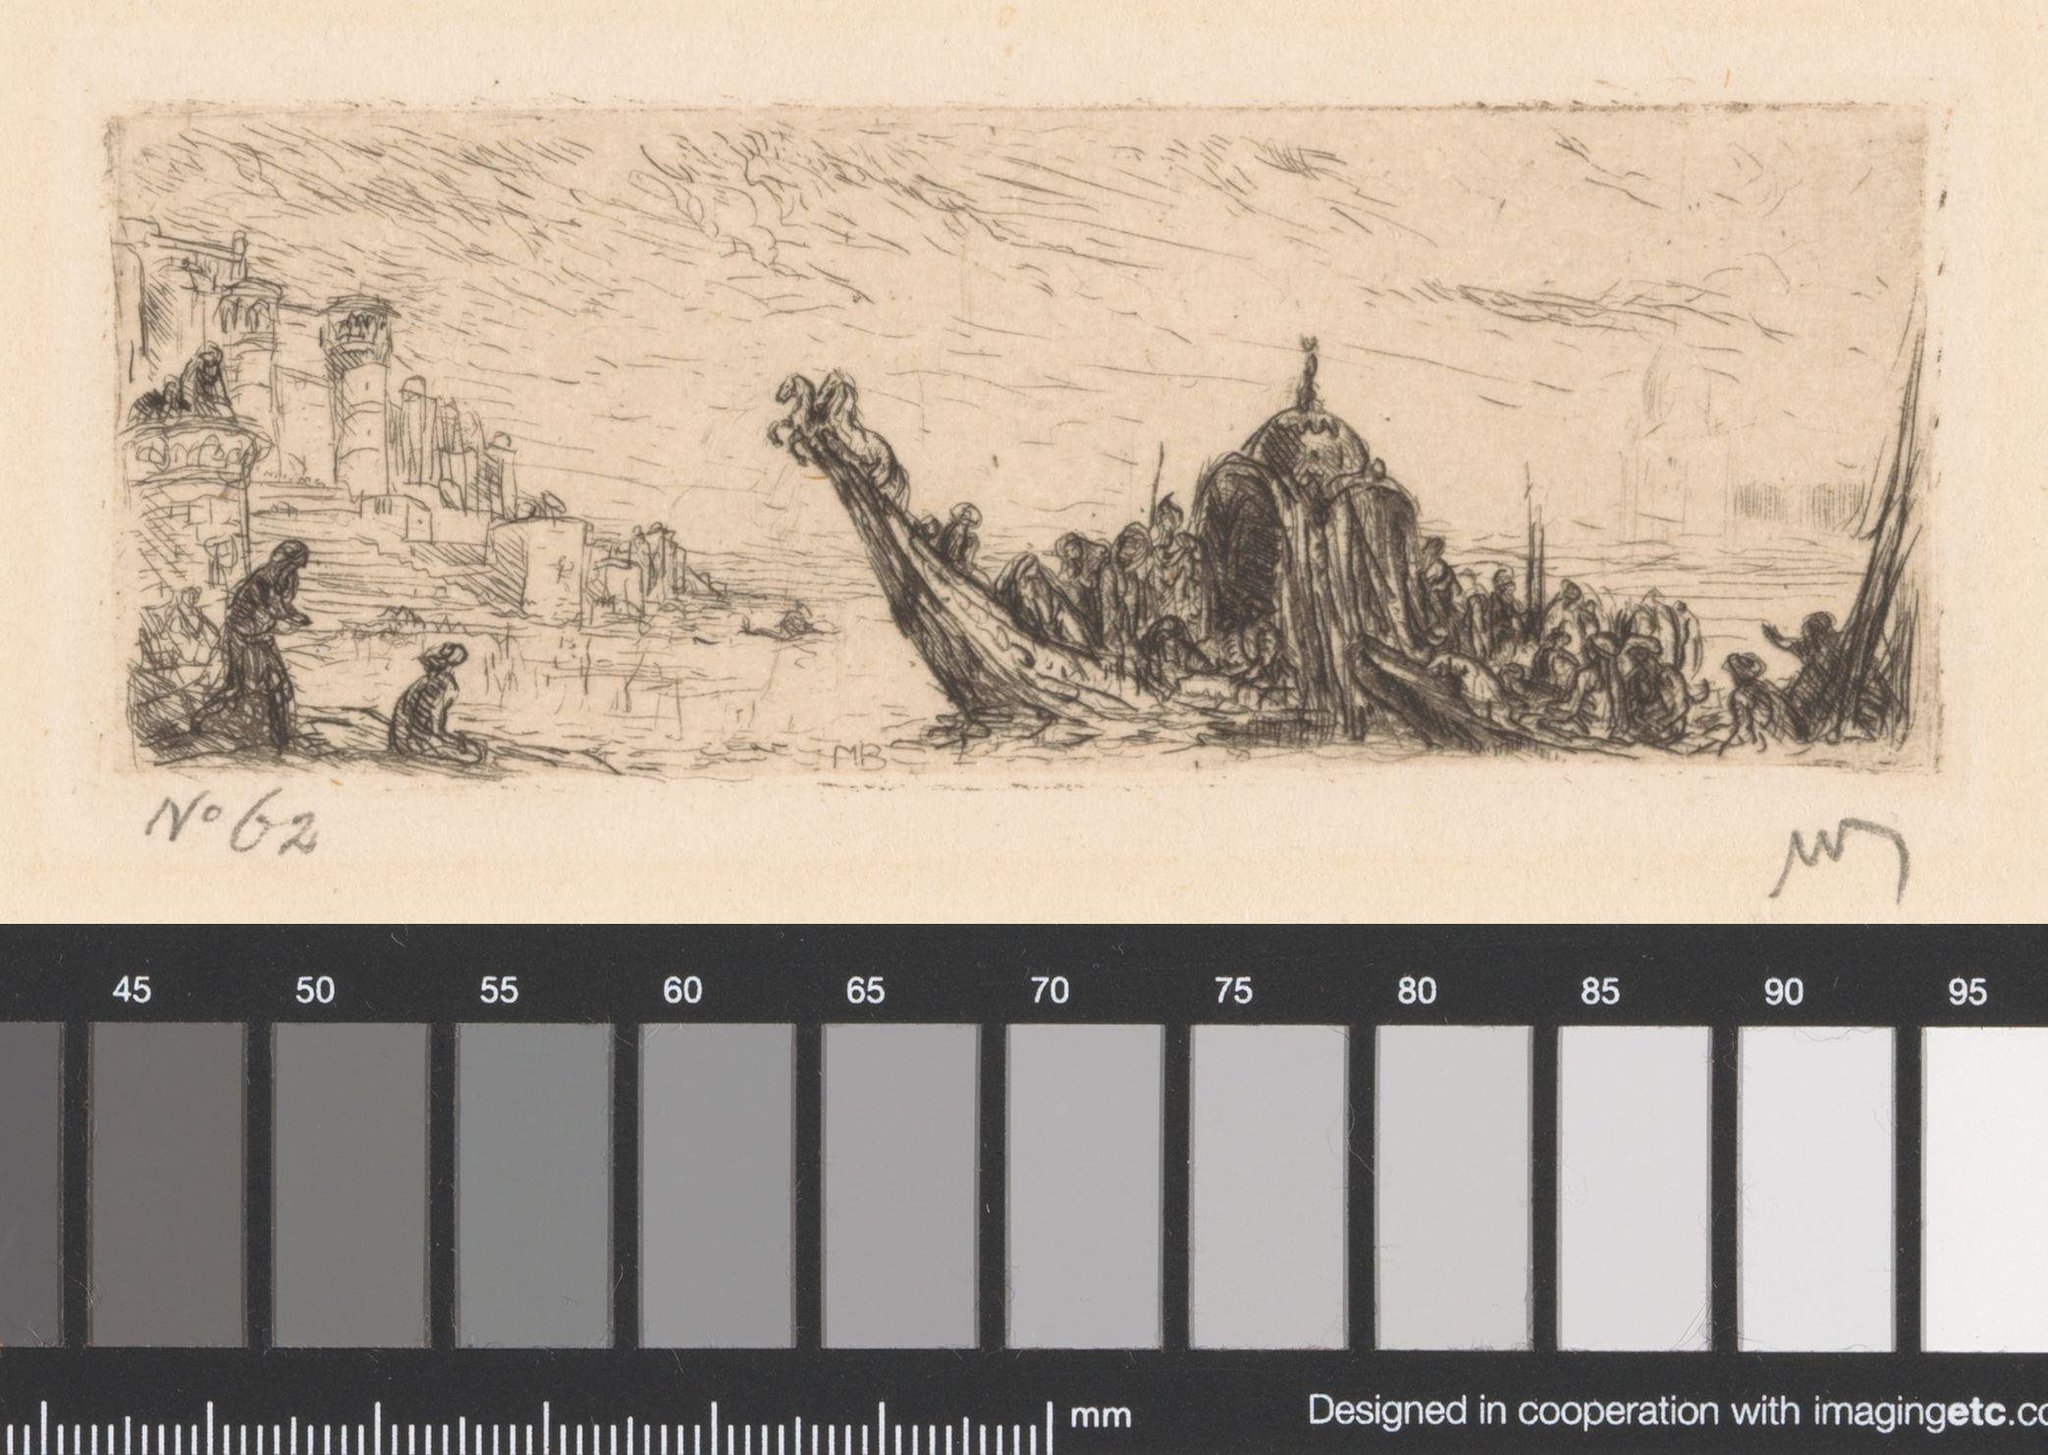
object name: print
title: Statiegondel in Benares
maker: marius bauer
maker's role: draughtsman, print maker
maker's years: 1867-1932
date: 1889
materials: paper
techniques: etching, intaglio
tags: river, gondola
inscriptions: collector's mark: Lugt 2228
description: Een statiegondel met passagiers op de Ganges in Benares.